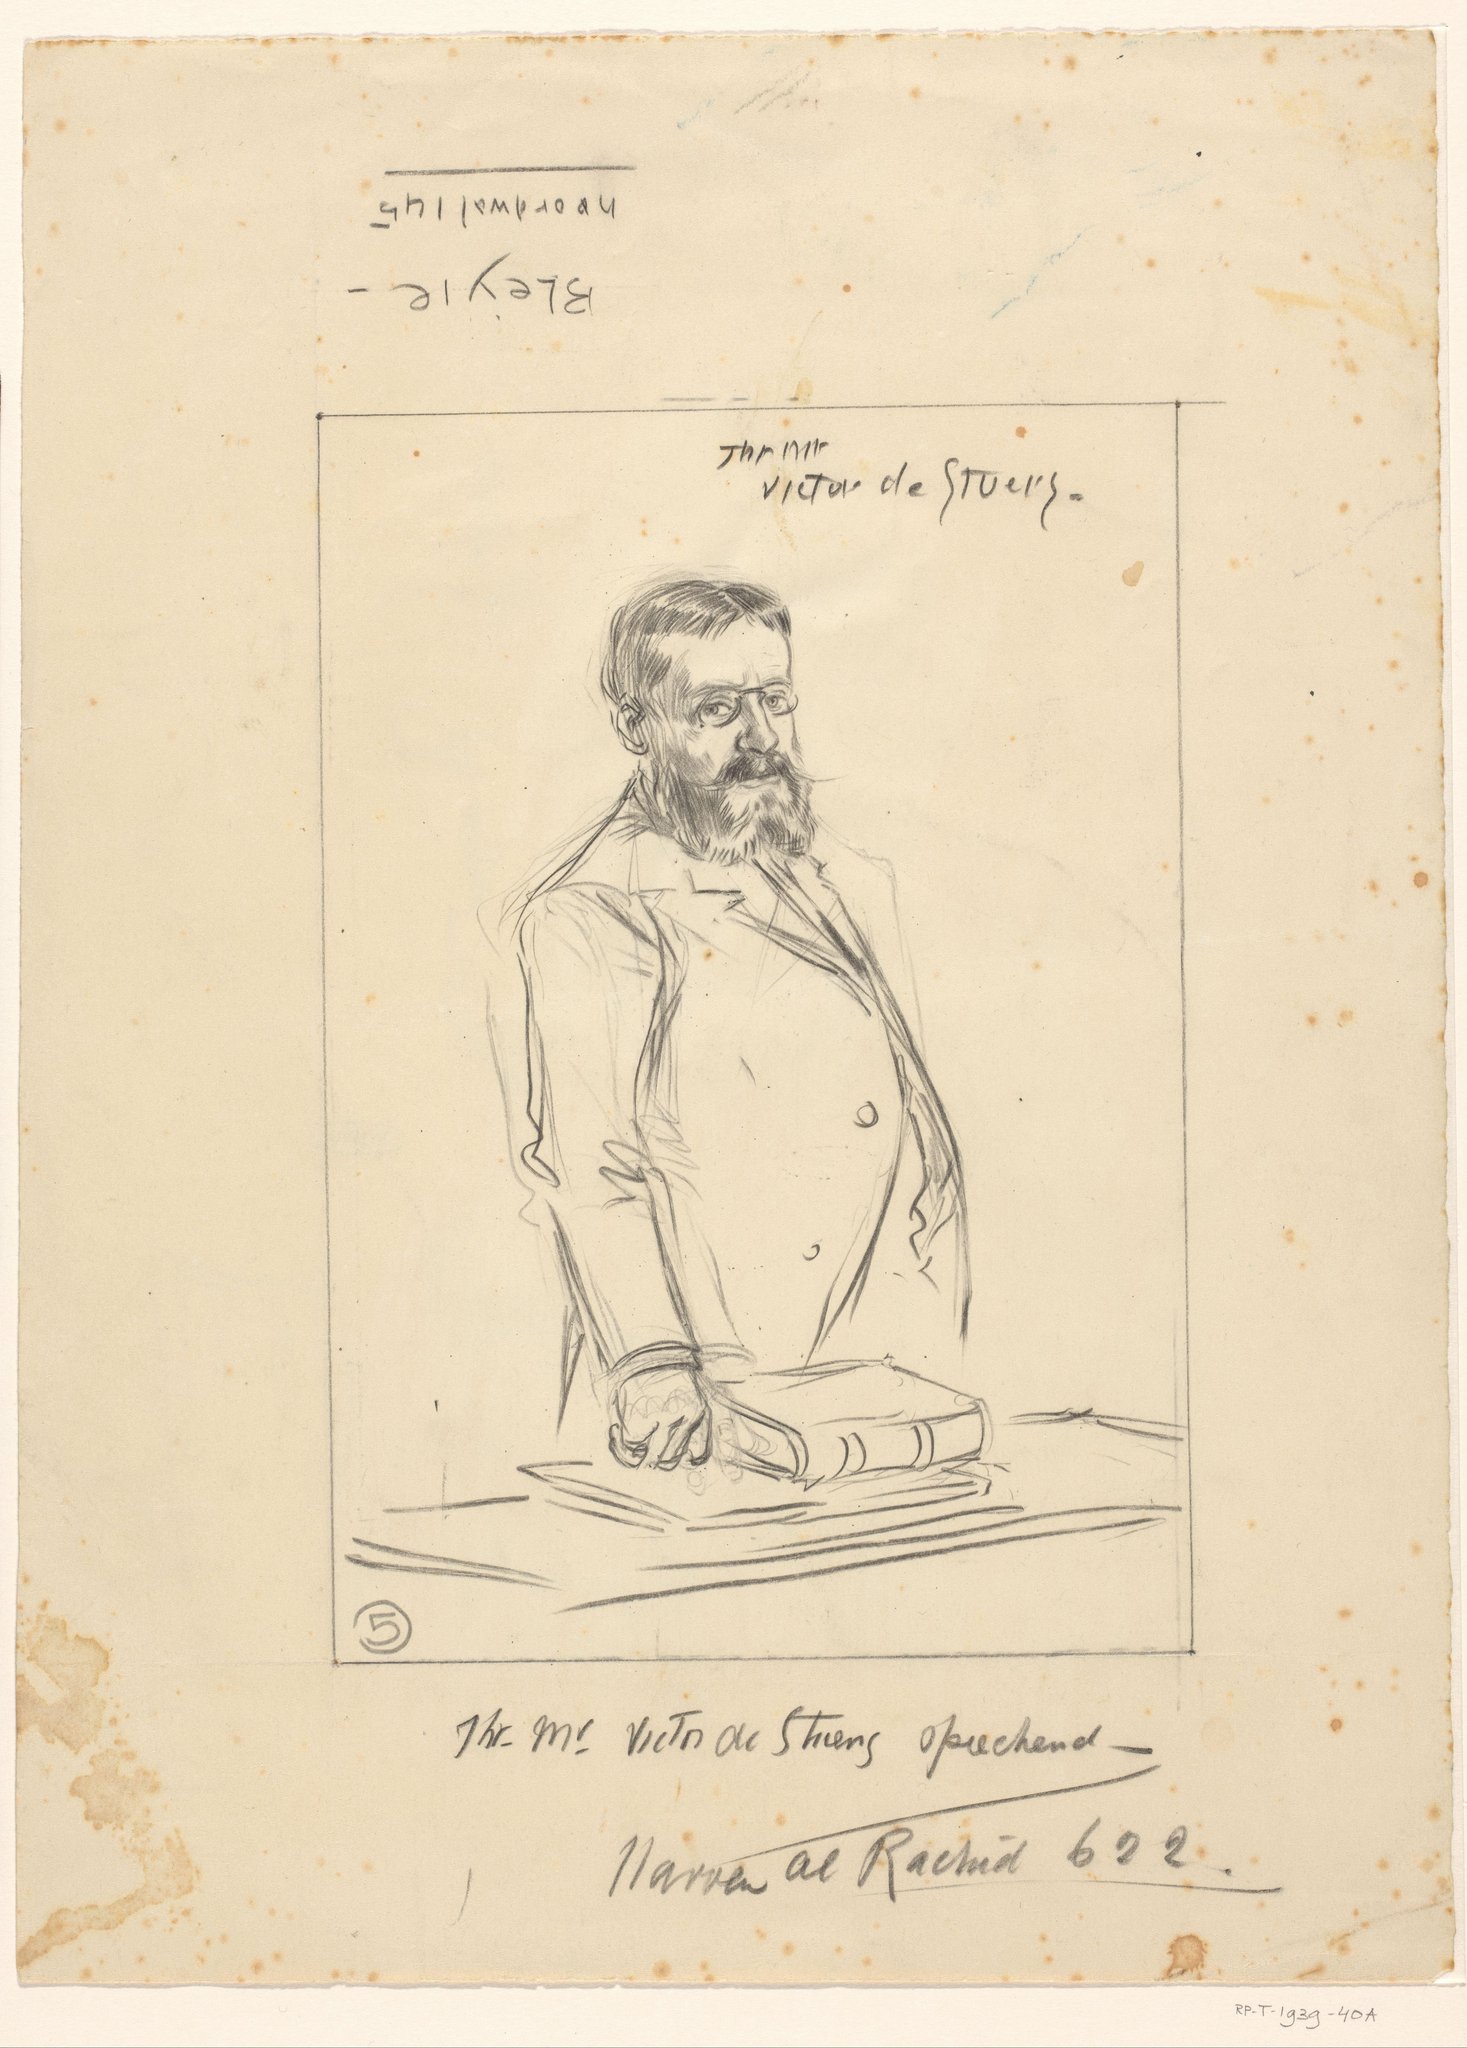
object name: drawing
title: Ontwerp voor een spotprent op Victor de Stuers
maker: henricus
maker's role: draughtsman, print maker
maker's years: 1867-1921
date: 1906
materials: chalk, paper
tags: maastricht, jonkheer victor eugène louis de stuers, historical persons, political caricatures and satires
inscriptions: number: ‘5’, collector's mark: Lugt 2228a, inscription: ‘Jhr. Mr. Victor de Stuers sprekend/ Na[...]en al Rachid 622.’, inscription: ‘BLEYIE-/ noordwal 145’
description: Ontwerp voor een spotprent voor: De Nederlandsche Spectator (1906), no. 46.